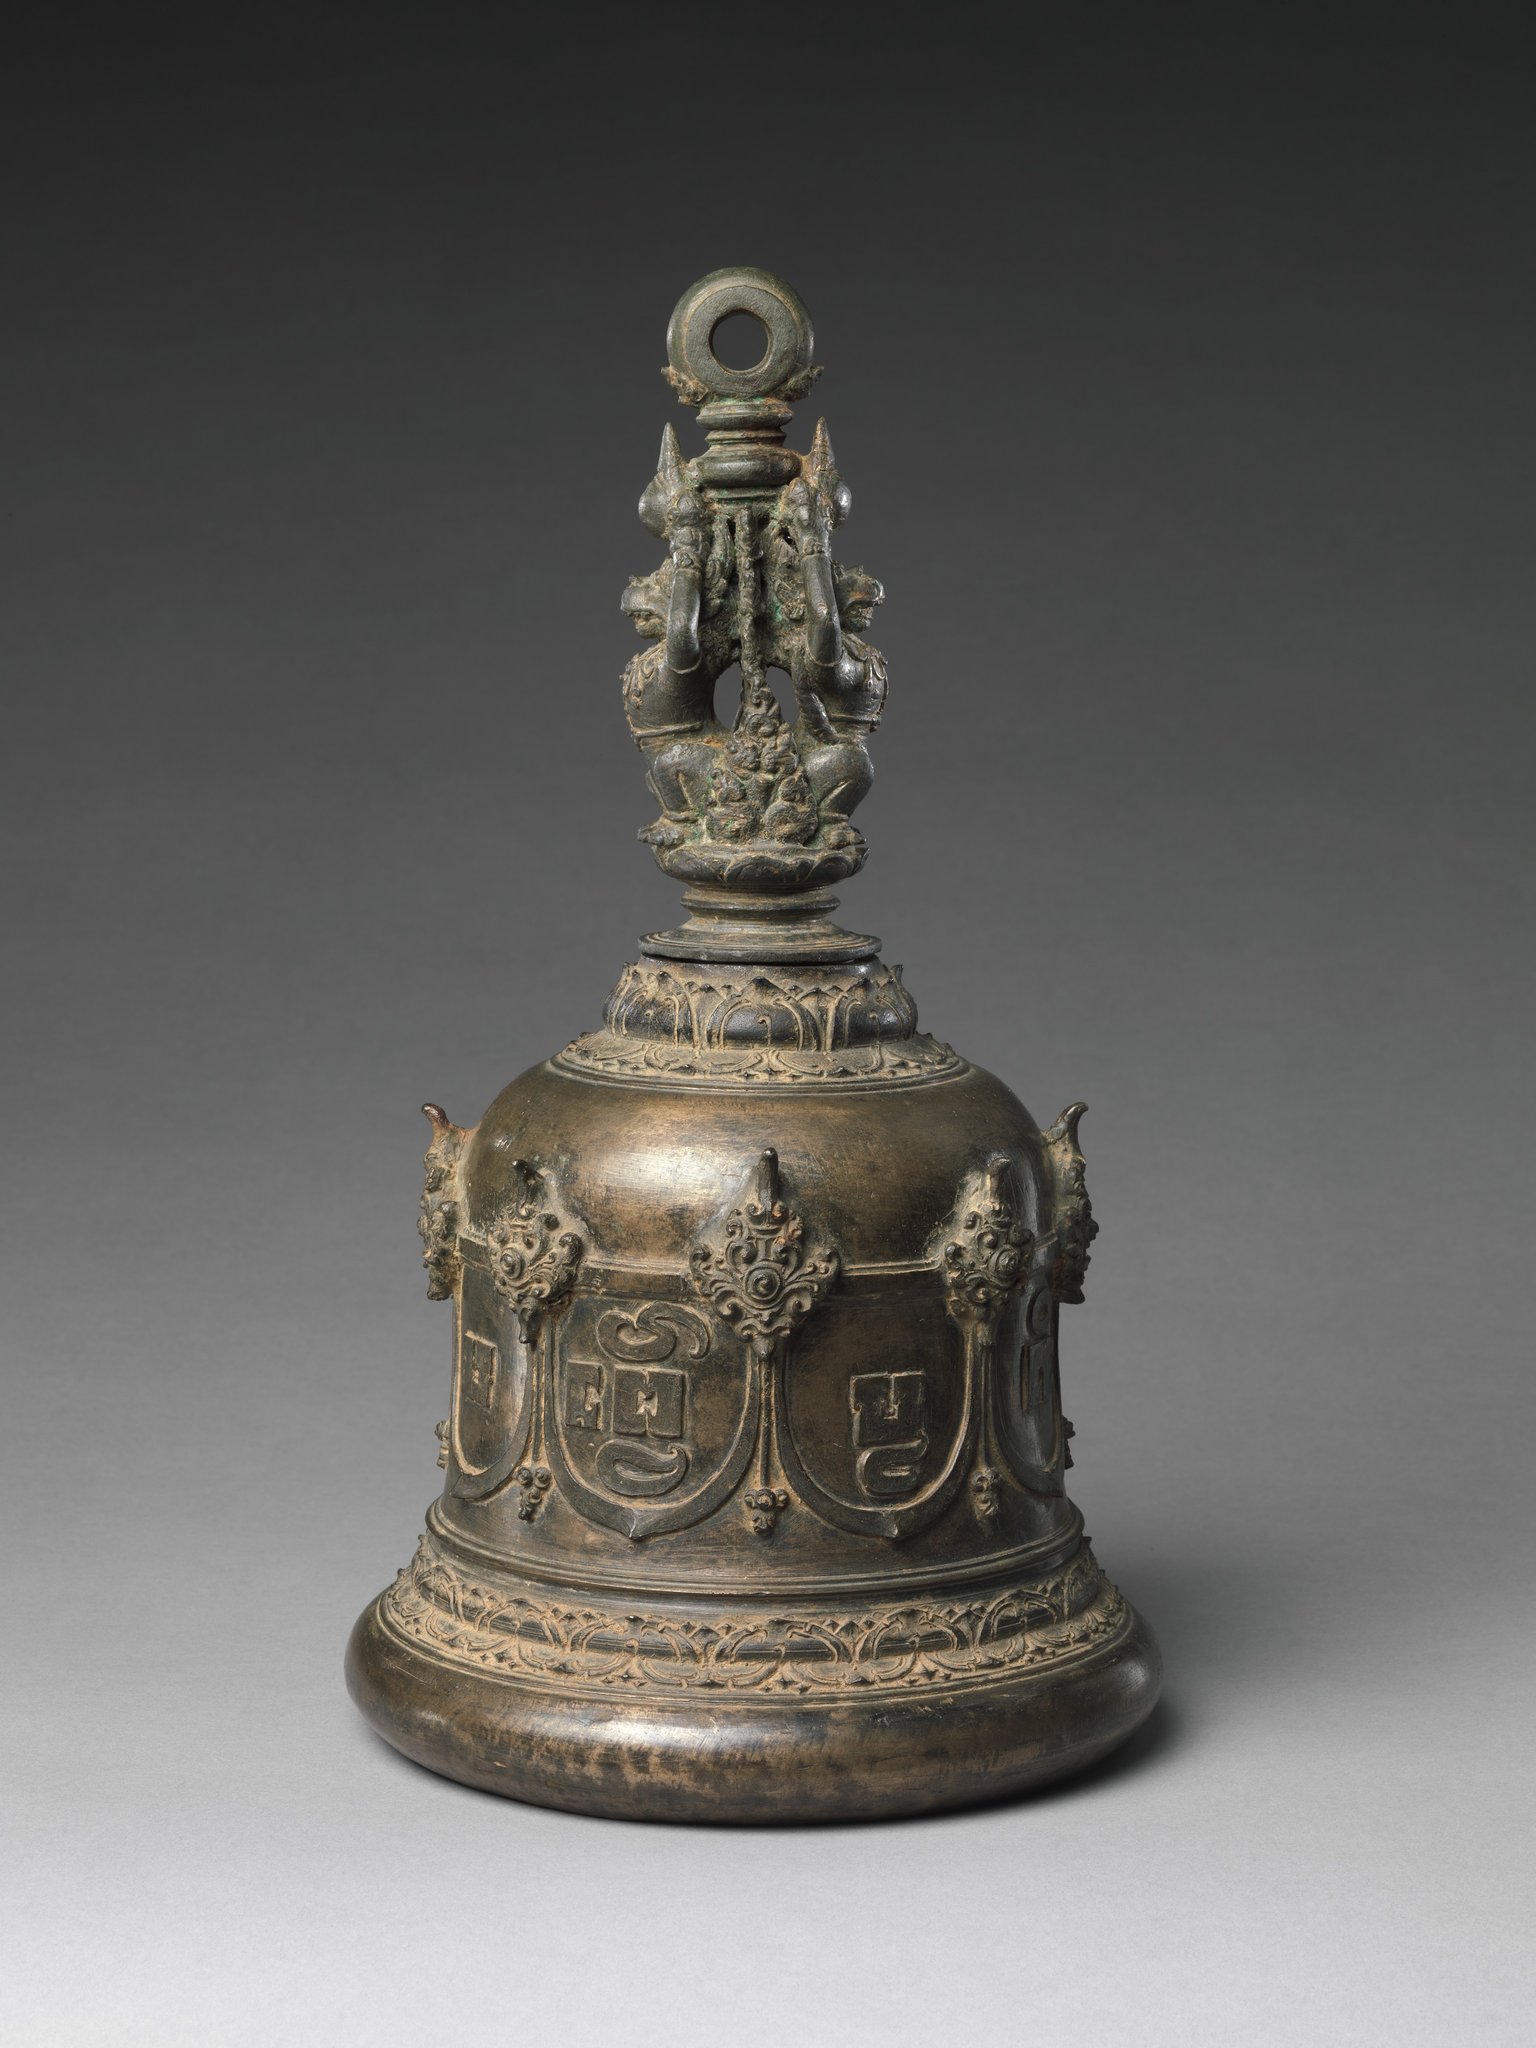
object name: bell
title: Temple Bell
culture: indonesian, javanese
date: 1001-1200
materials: bronze